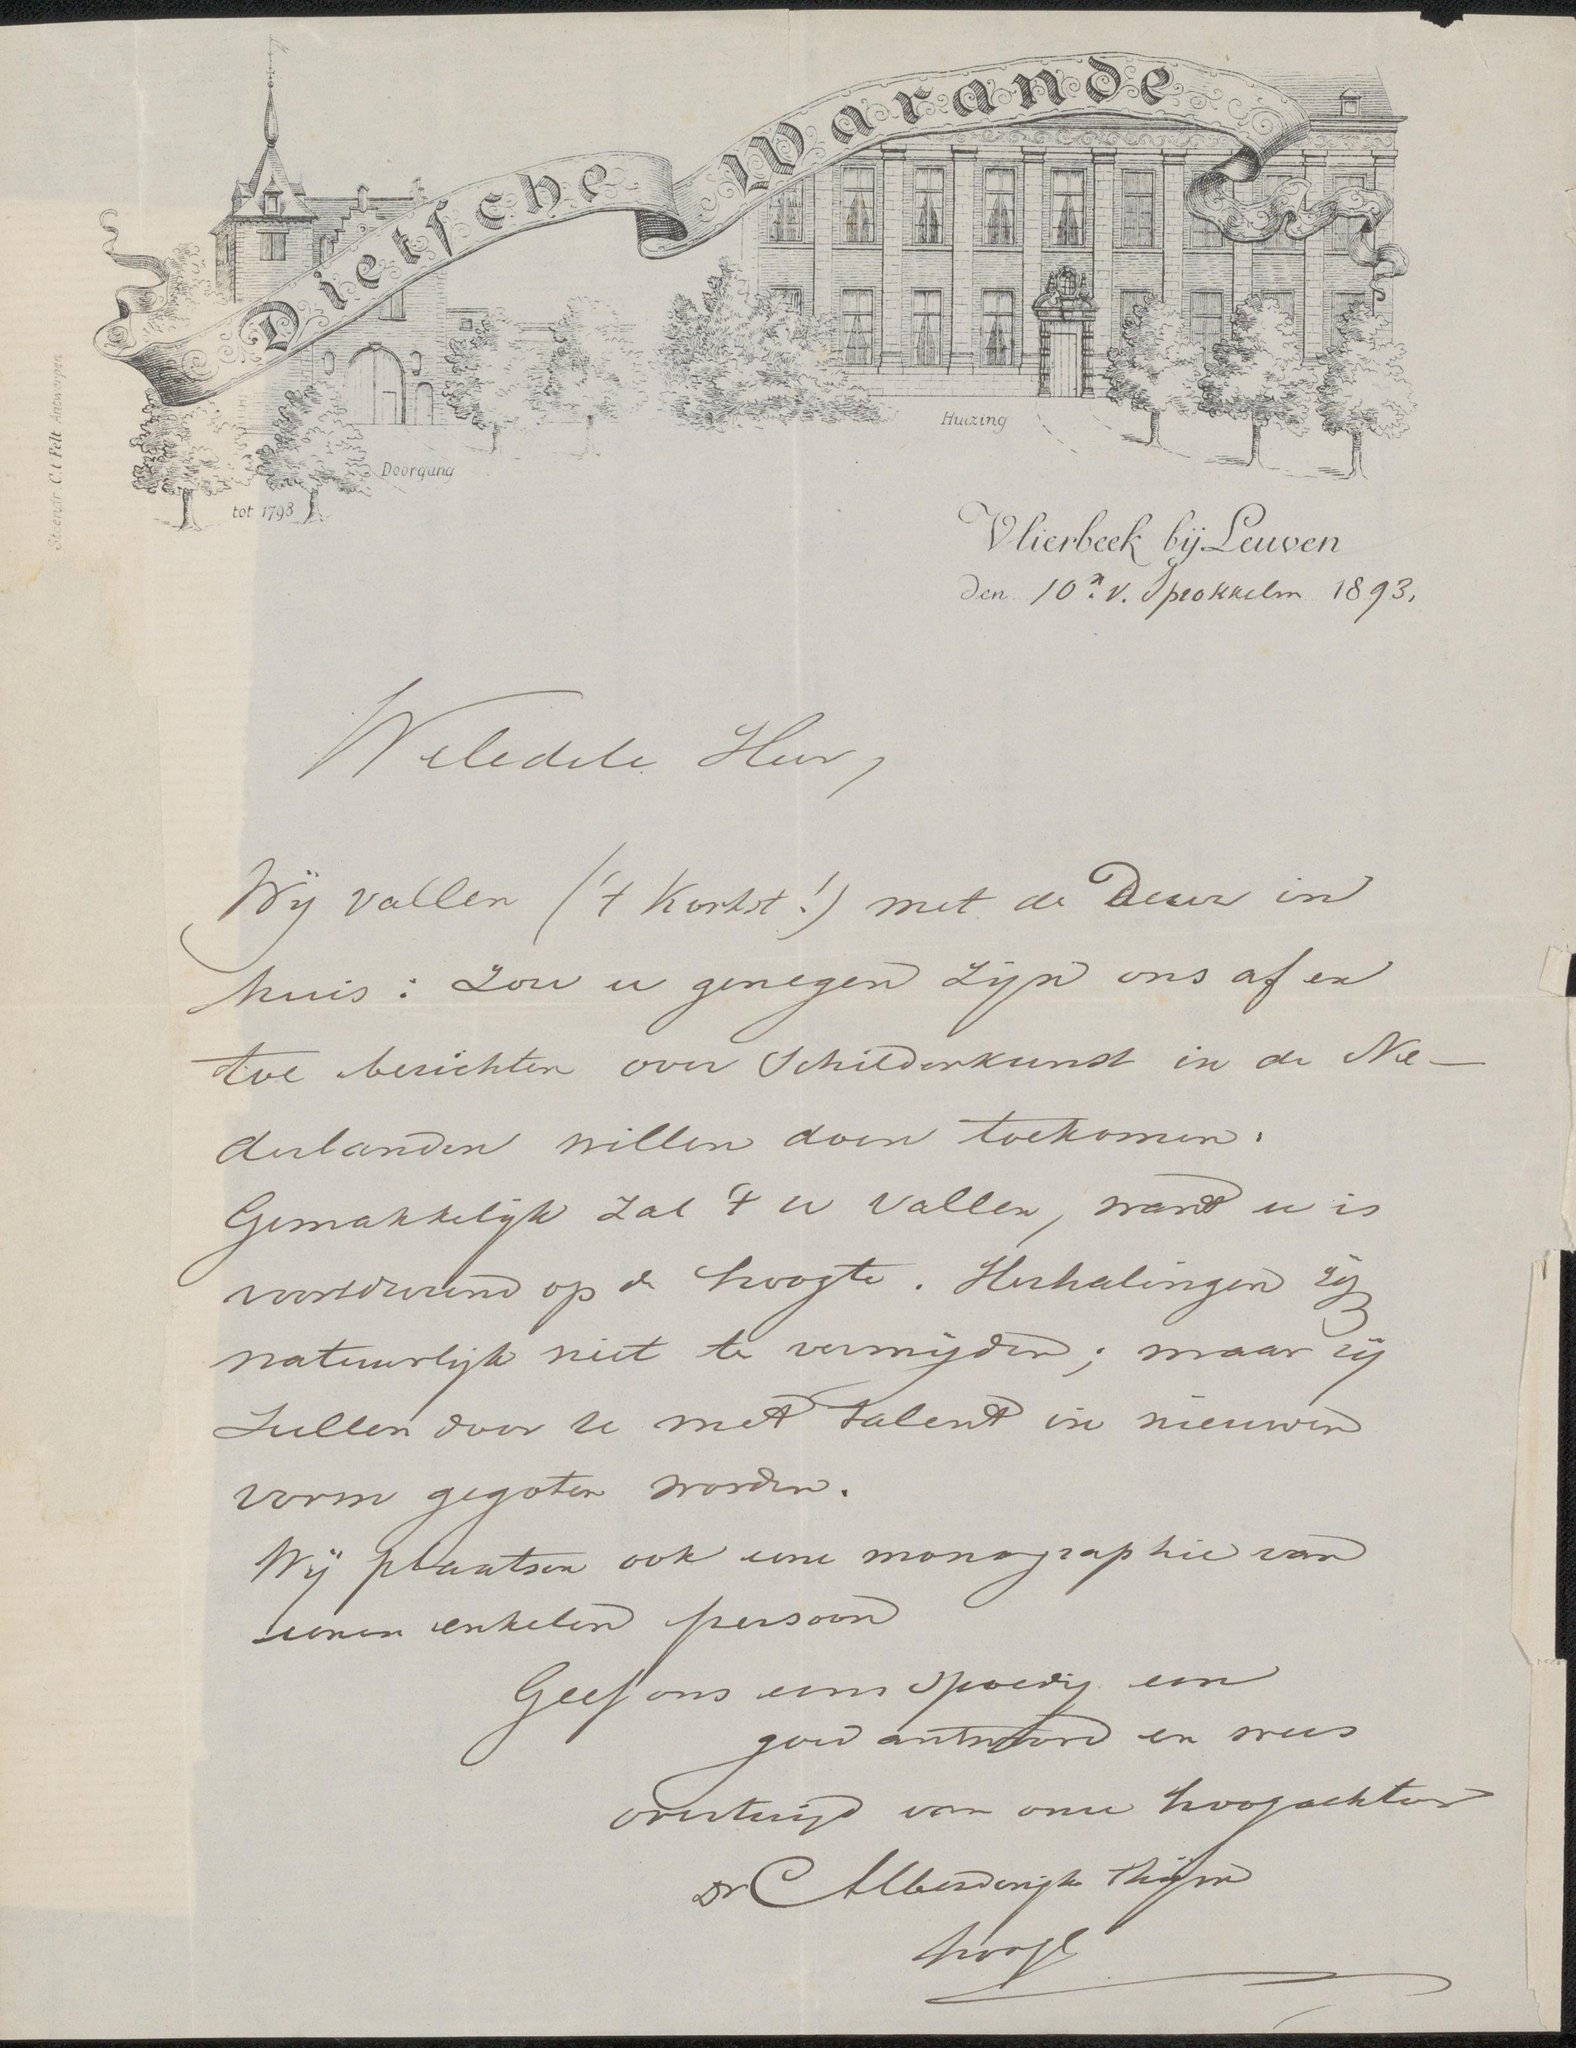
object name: letter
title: Brief aan Jan Veth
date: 1893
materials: ink, paper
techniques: pen, printing, writing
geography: vlierbeek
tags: dordrecht, amsterdam, painter, print maker, draughtsman, designer, jan veth, painting (including book-illumination, miniature-painting)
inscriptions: collector's mark: ‘RPK’